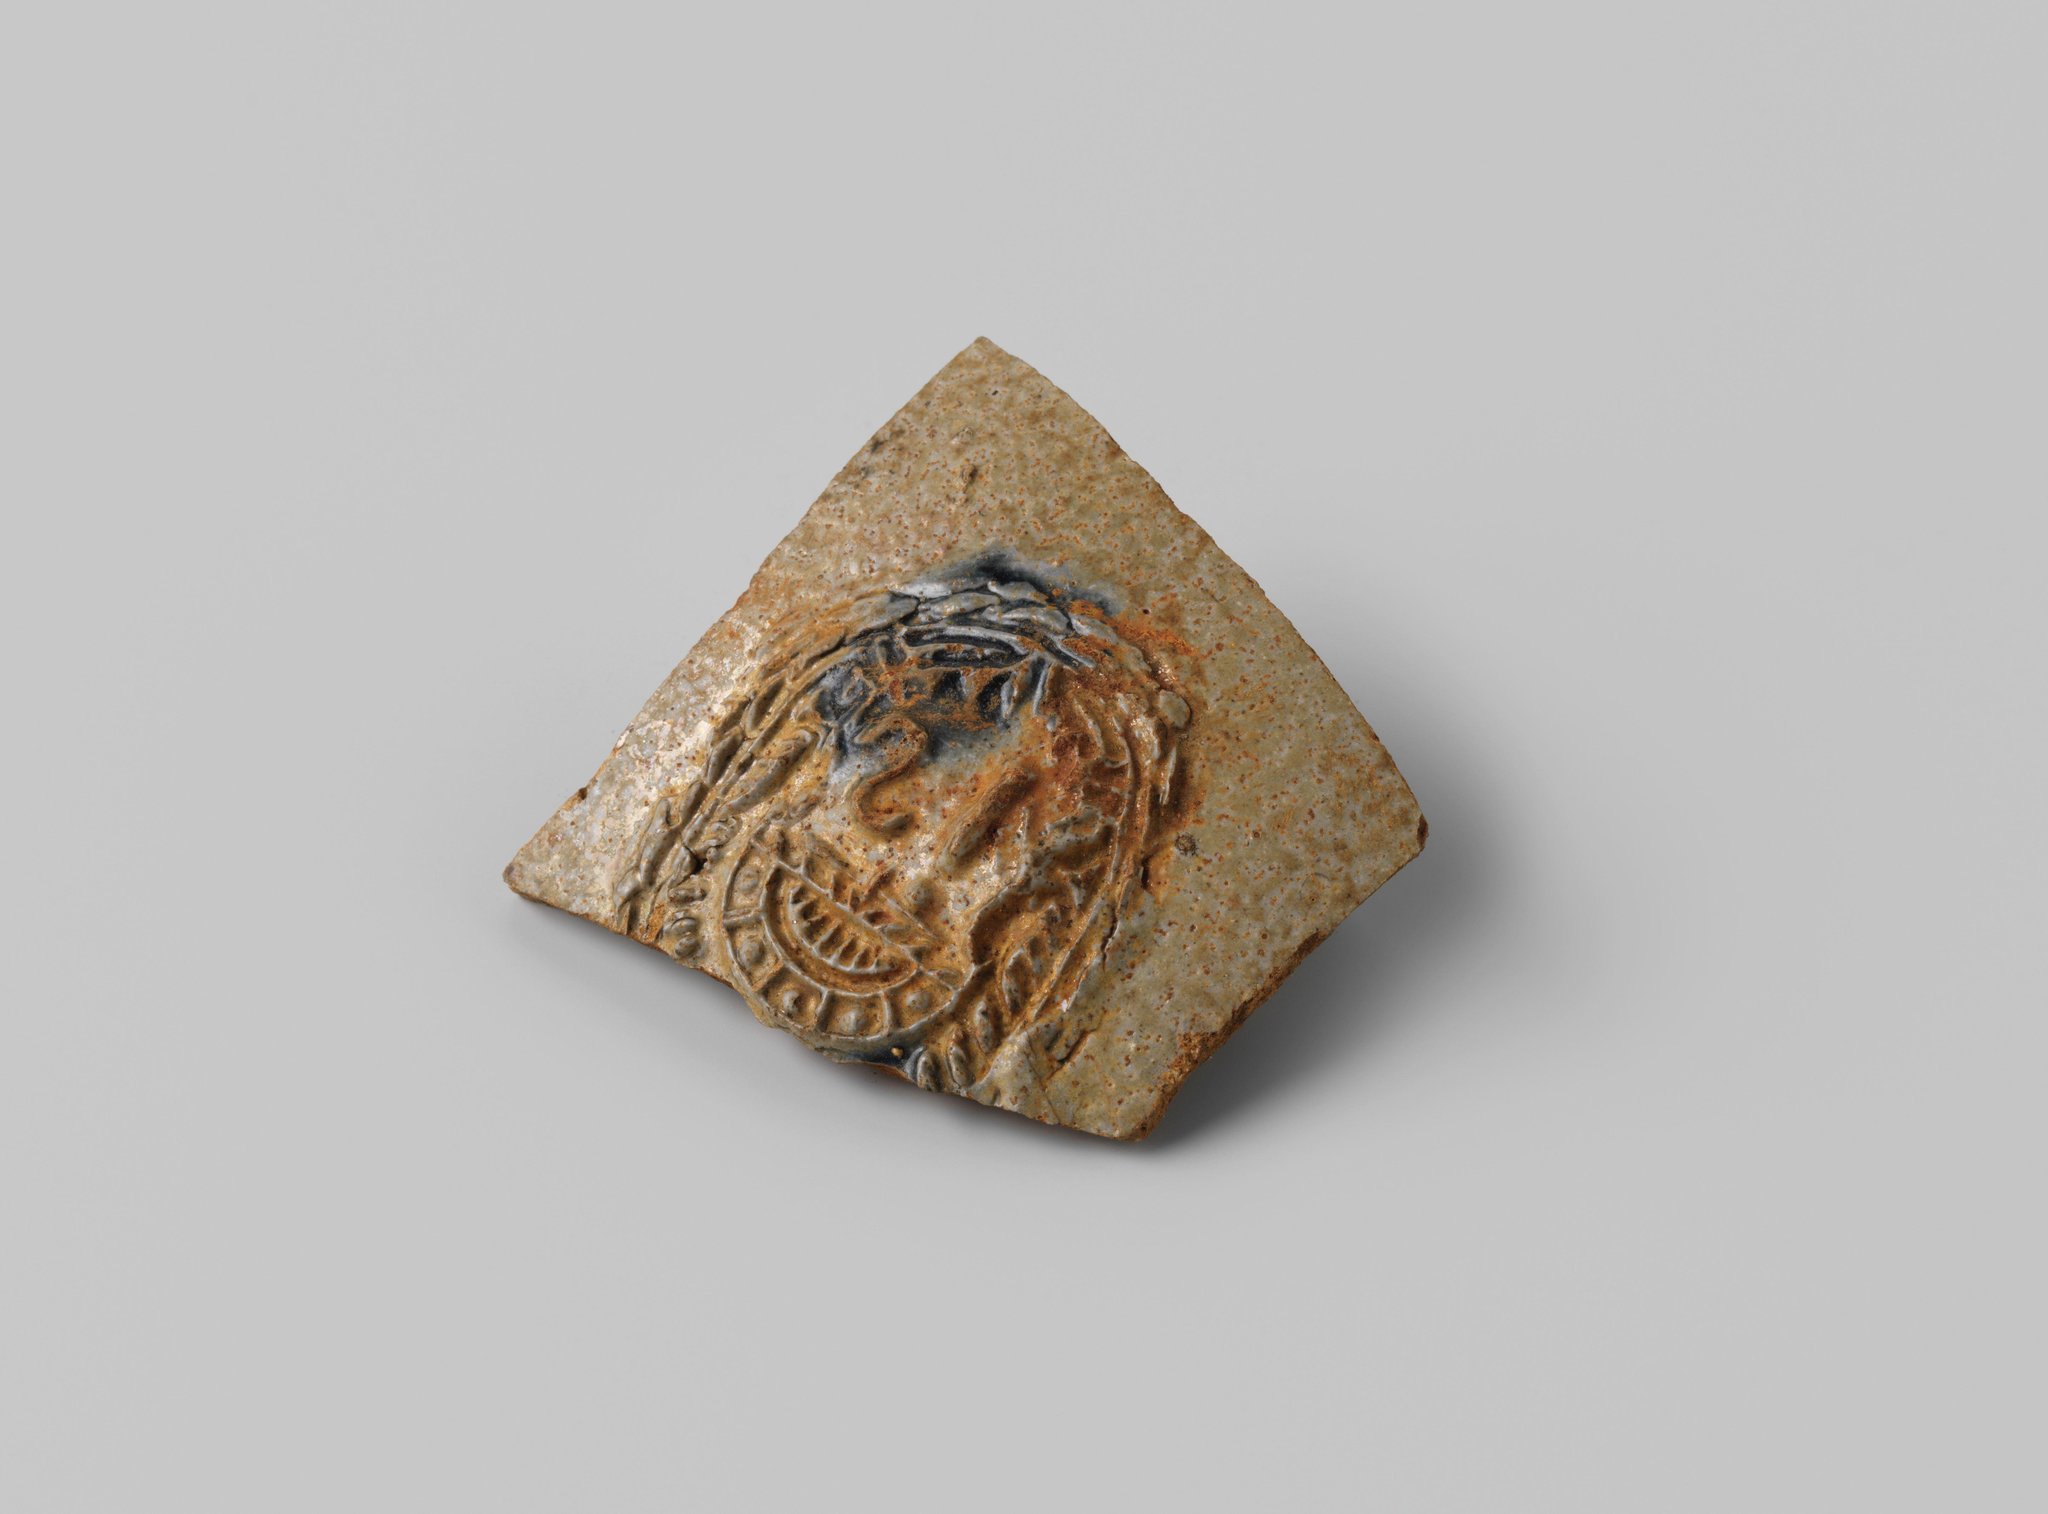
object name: ewer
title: Scherf van een steengoed kan uit het wrak van de Oost-Indiëvaarder Princesse Maria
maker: Anonymous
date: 1670-1686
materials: stoneware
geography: netherlands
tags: princesse maria (schip), verenigde oostindische compagnie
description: Scherf van een stuk steengoed. Van binnen beige, van buiten reliëfstempel.